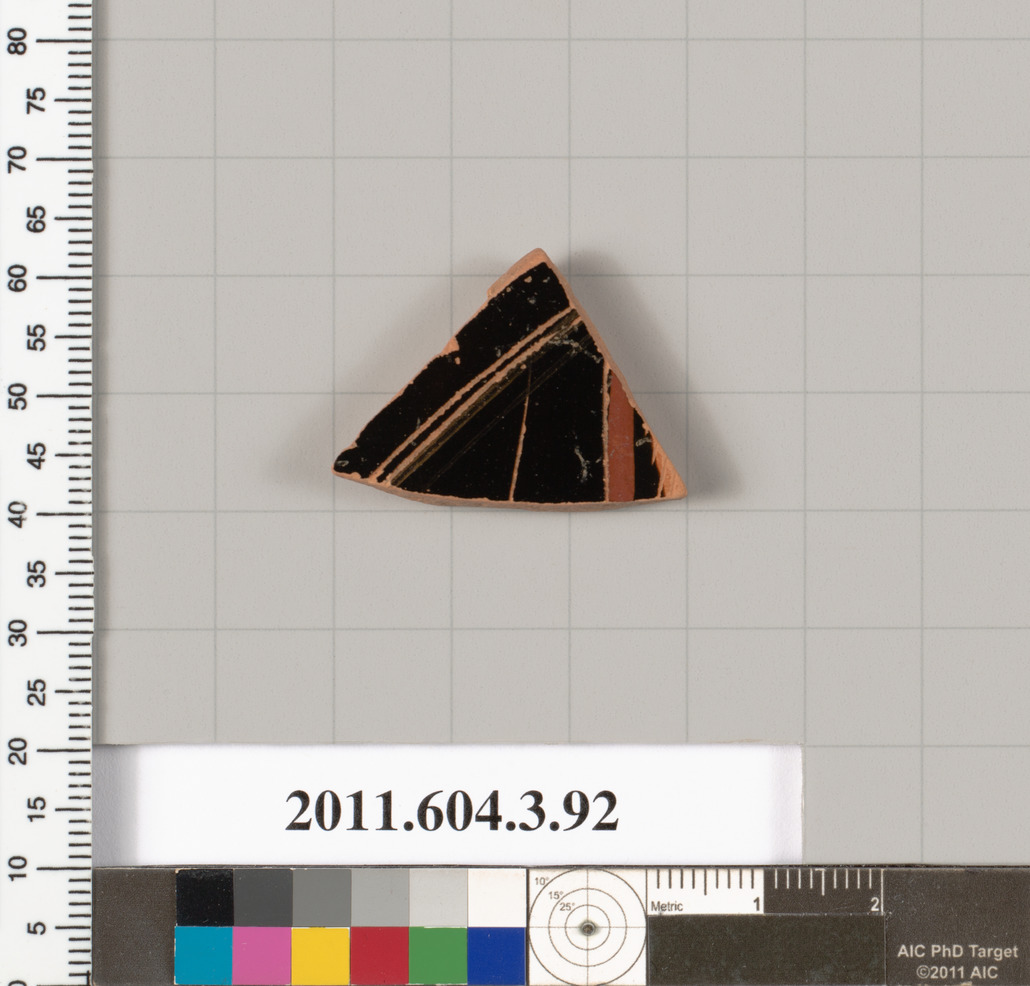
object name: amphora fragment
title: Terracotta fragment of an amphora (jar)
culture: greek, attic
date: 550-501 BCE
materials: terracotta